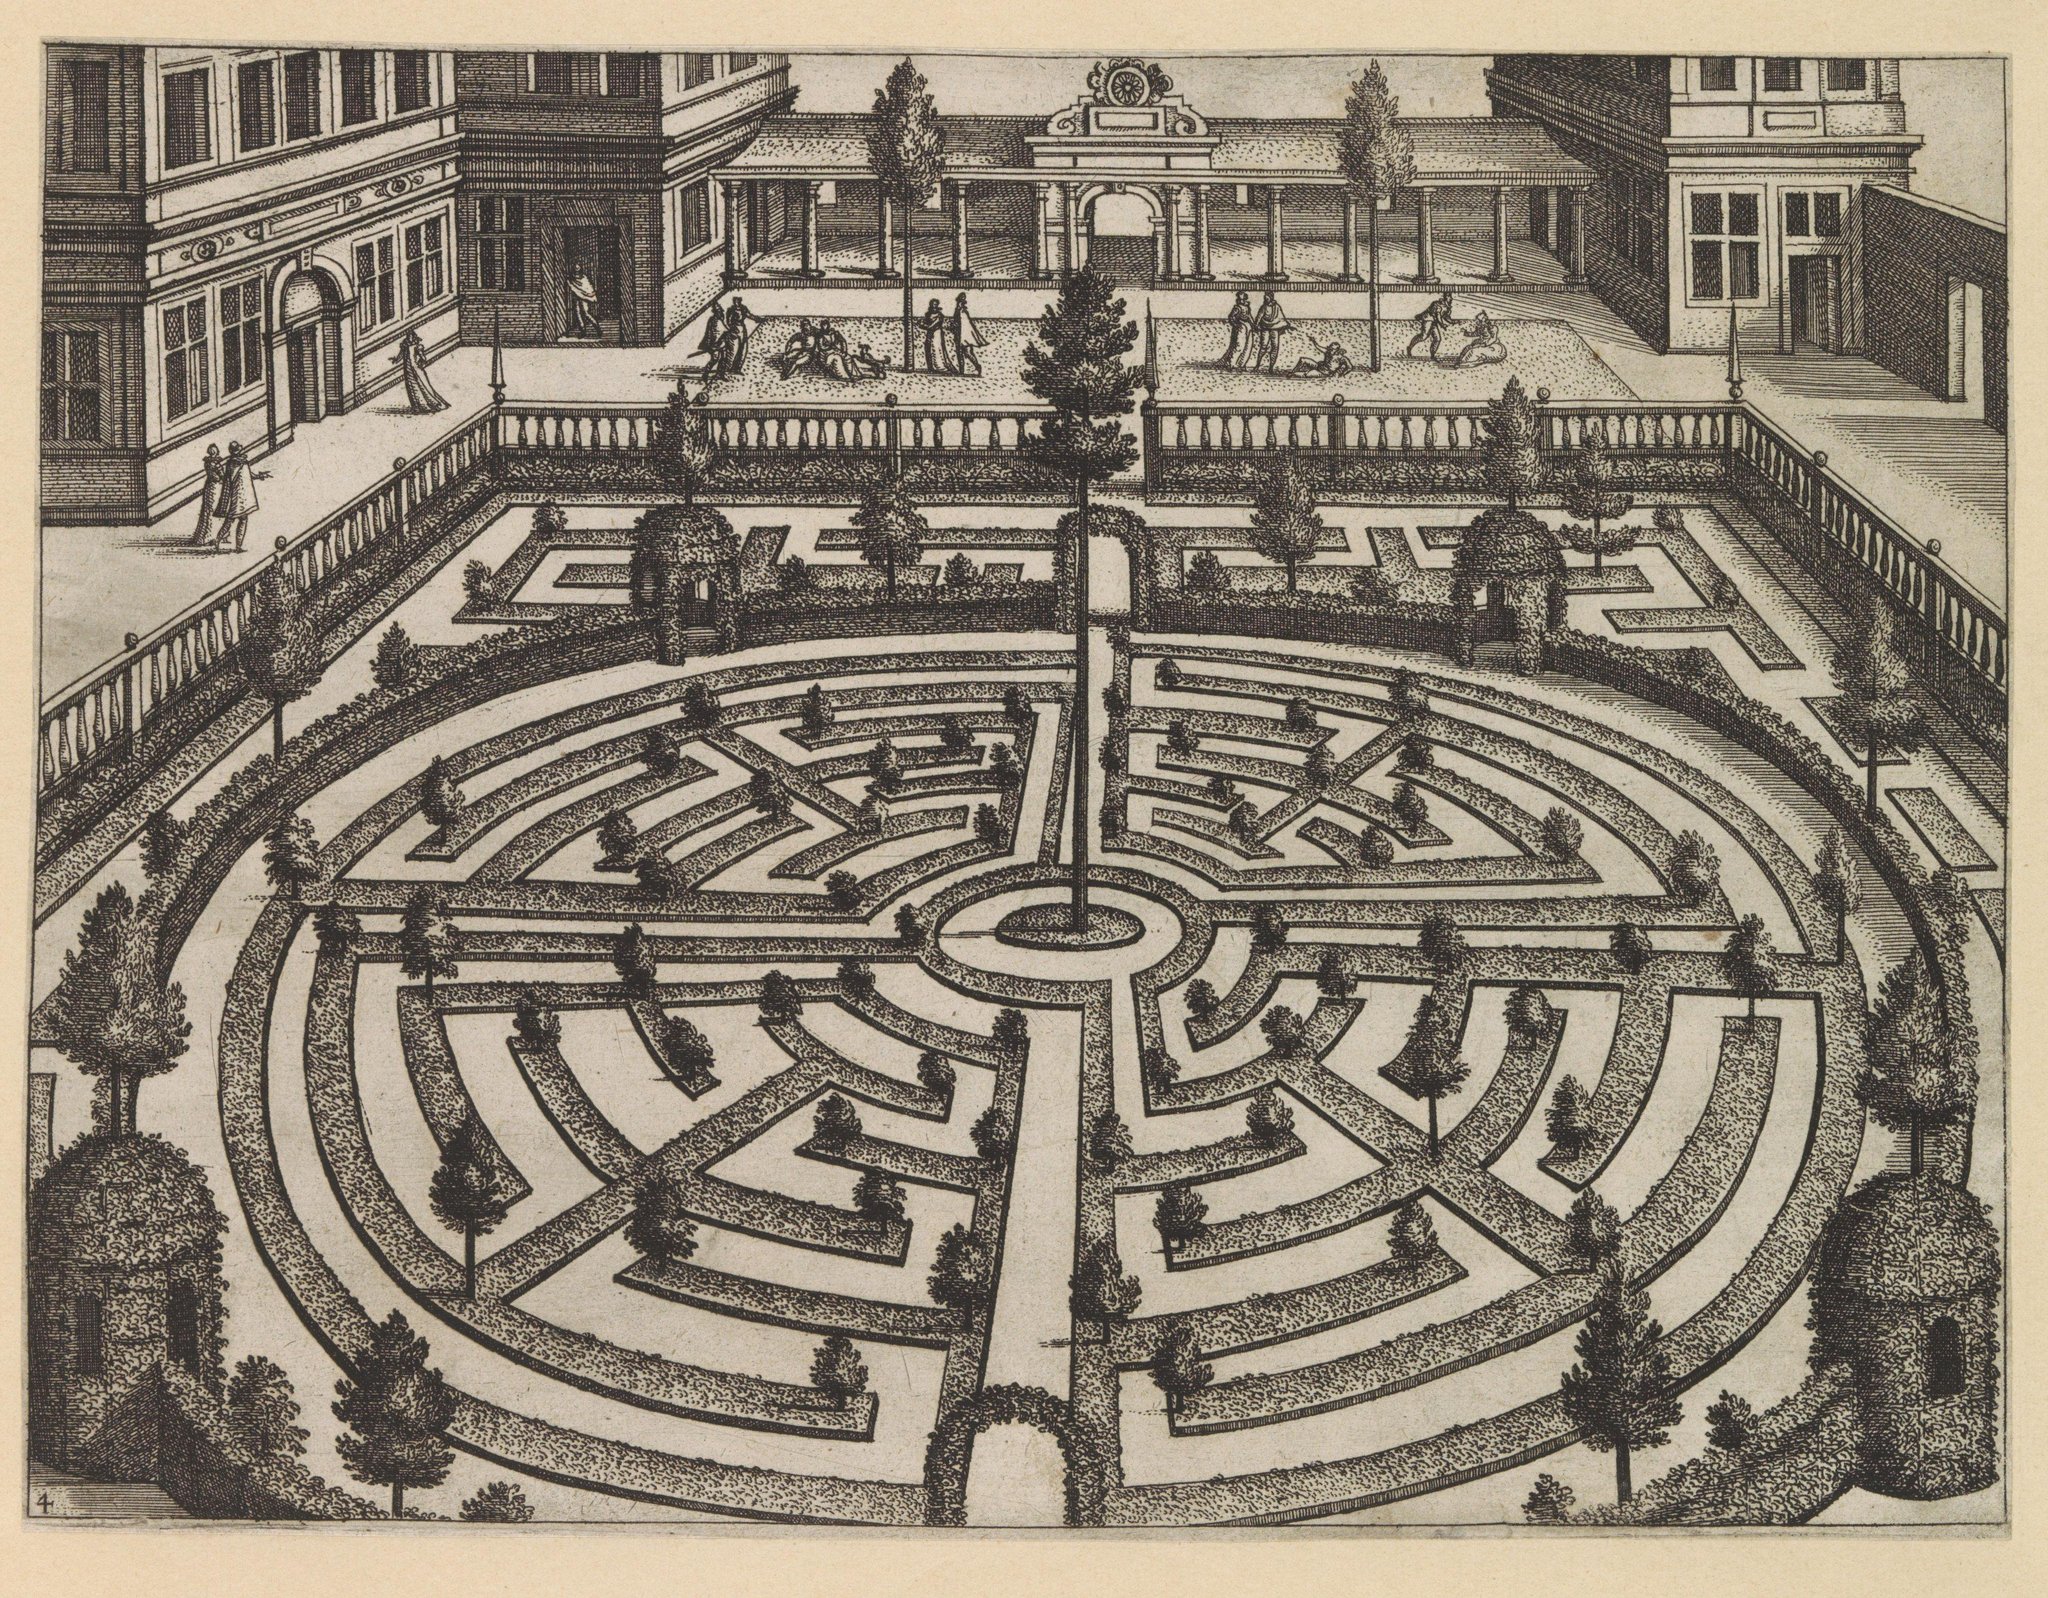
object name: album leaf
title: Hortorum Viridariorumque elegantes et multiplicis formae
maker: Anonymous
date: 1587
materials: paper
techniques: etching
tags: garden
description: Tuin met een ronde parterre, omgeven door een haag en een balustrade. Op de achtergrond een zuilengang. Daarvoor zitten en staan mensen op het gras. De prent maakt deel uit van een album.